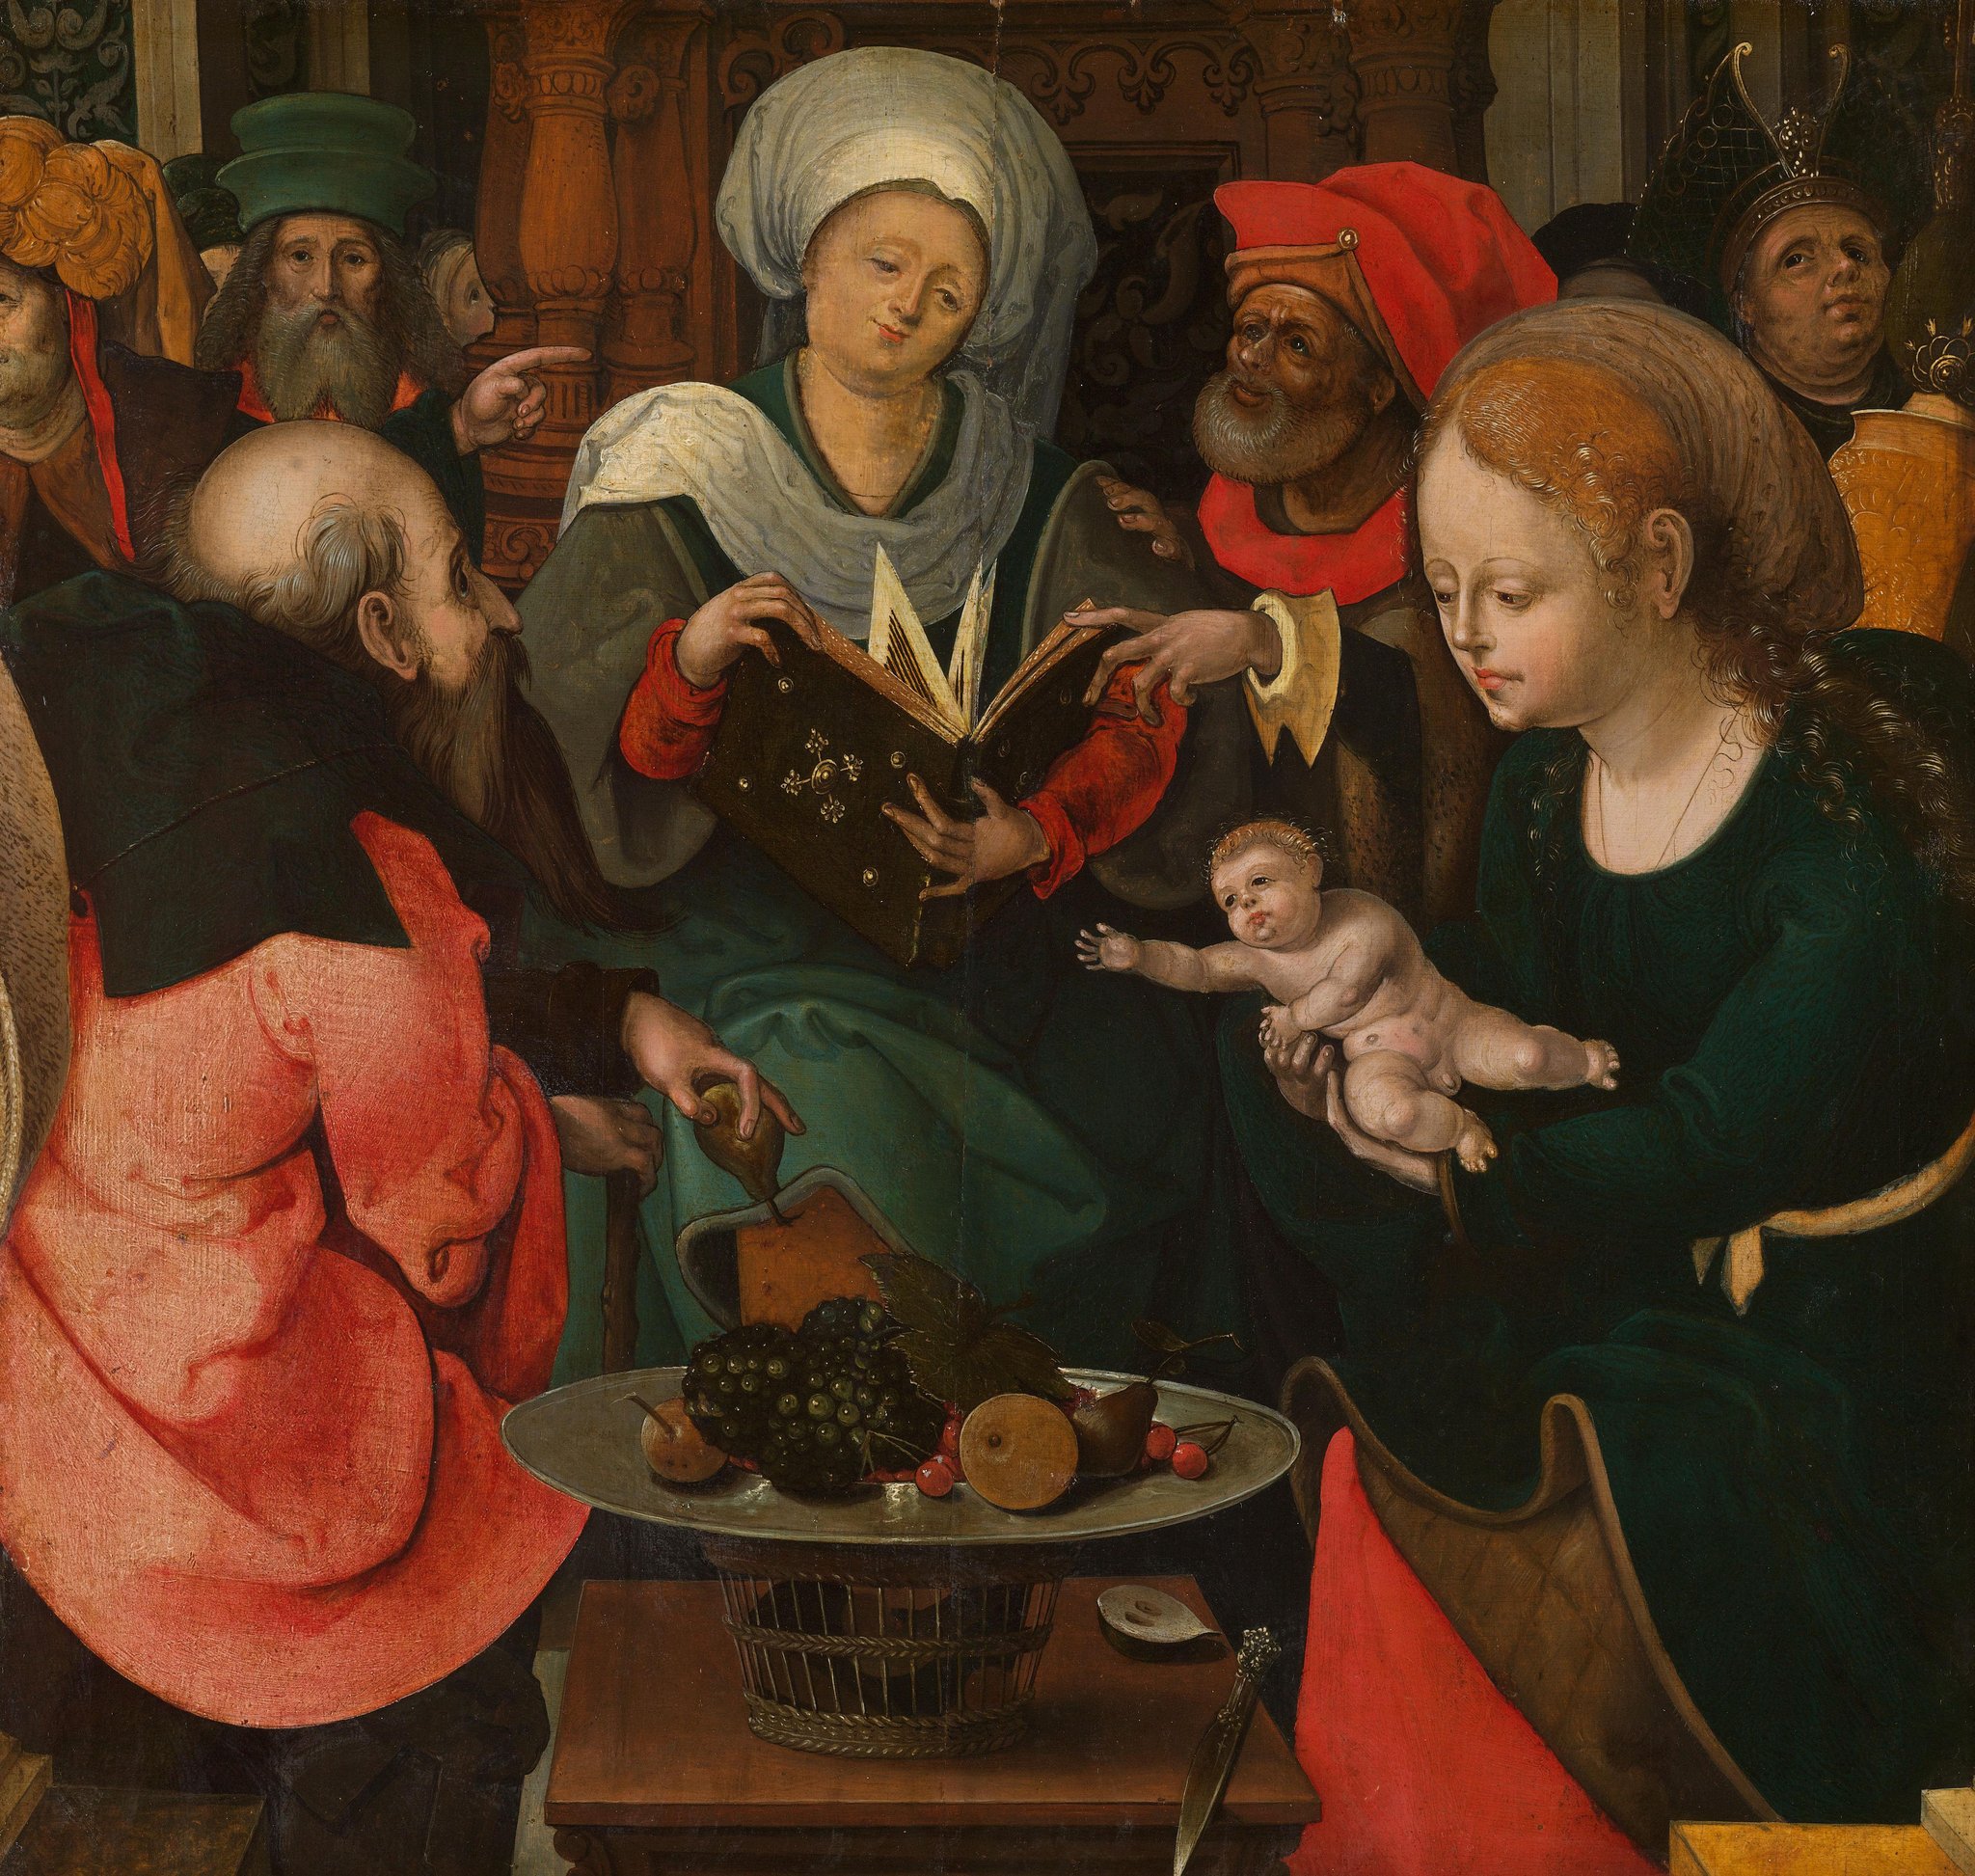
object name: painting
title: Holy Kinship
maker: master of the lille adoration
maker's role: painter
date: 1520-1530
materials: oil, panel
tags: holy kinship, 'anna selbdritt' with joseph present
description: De heilige maagschap. Maria met kind en Anna, in het midden een schaal met fruit. Anna heeft een opengeslagen boek op schoot. Kopie naar het middenpaneel in de Stiftsgalerie te Kremsmünster toegeschreven aan Dirck Vellert.